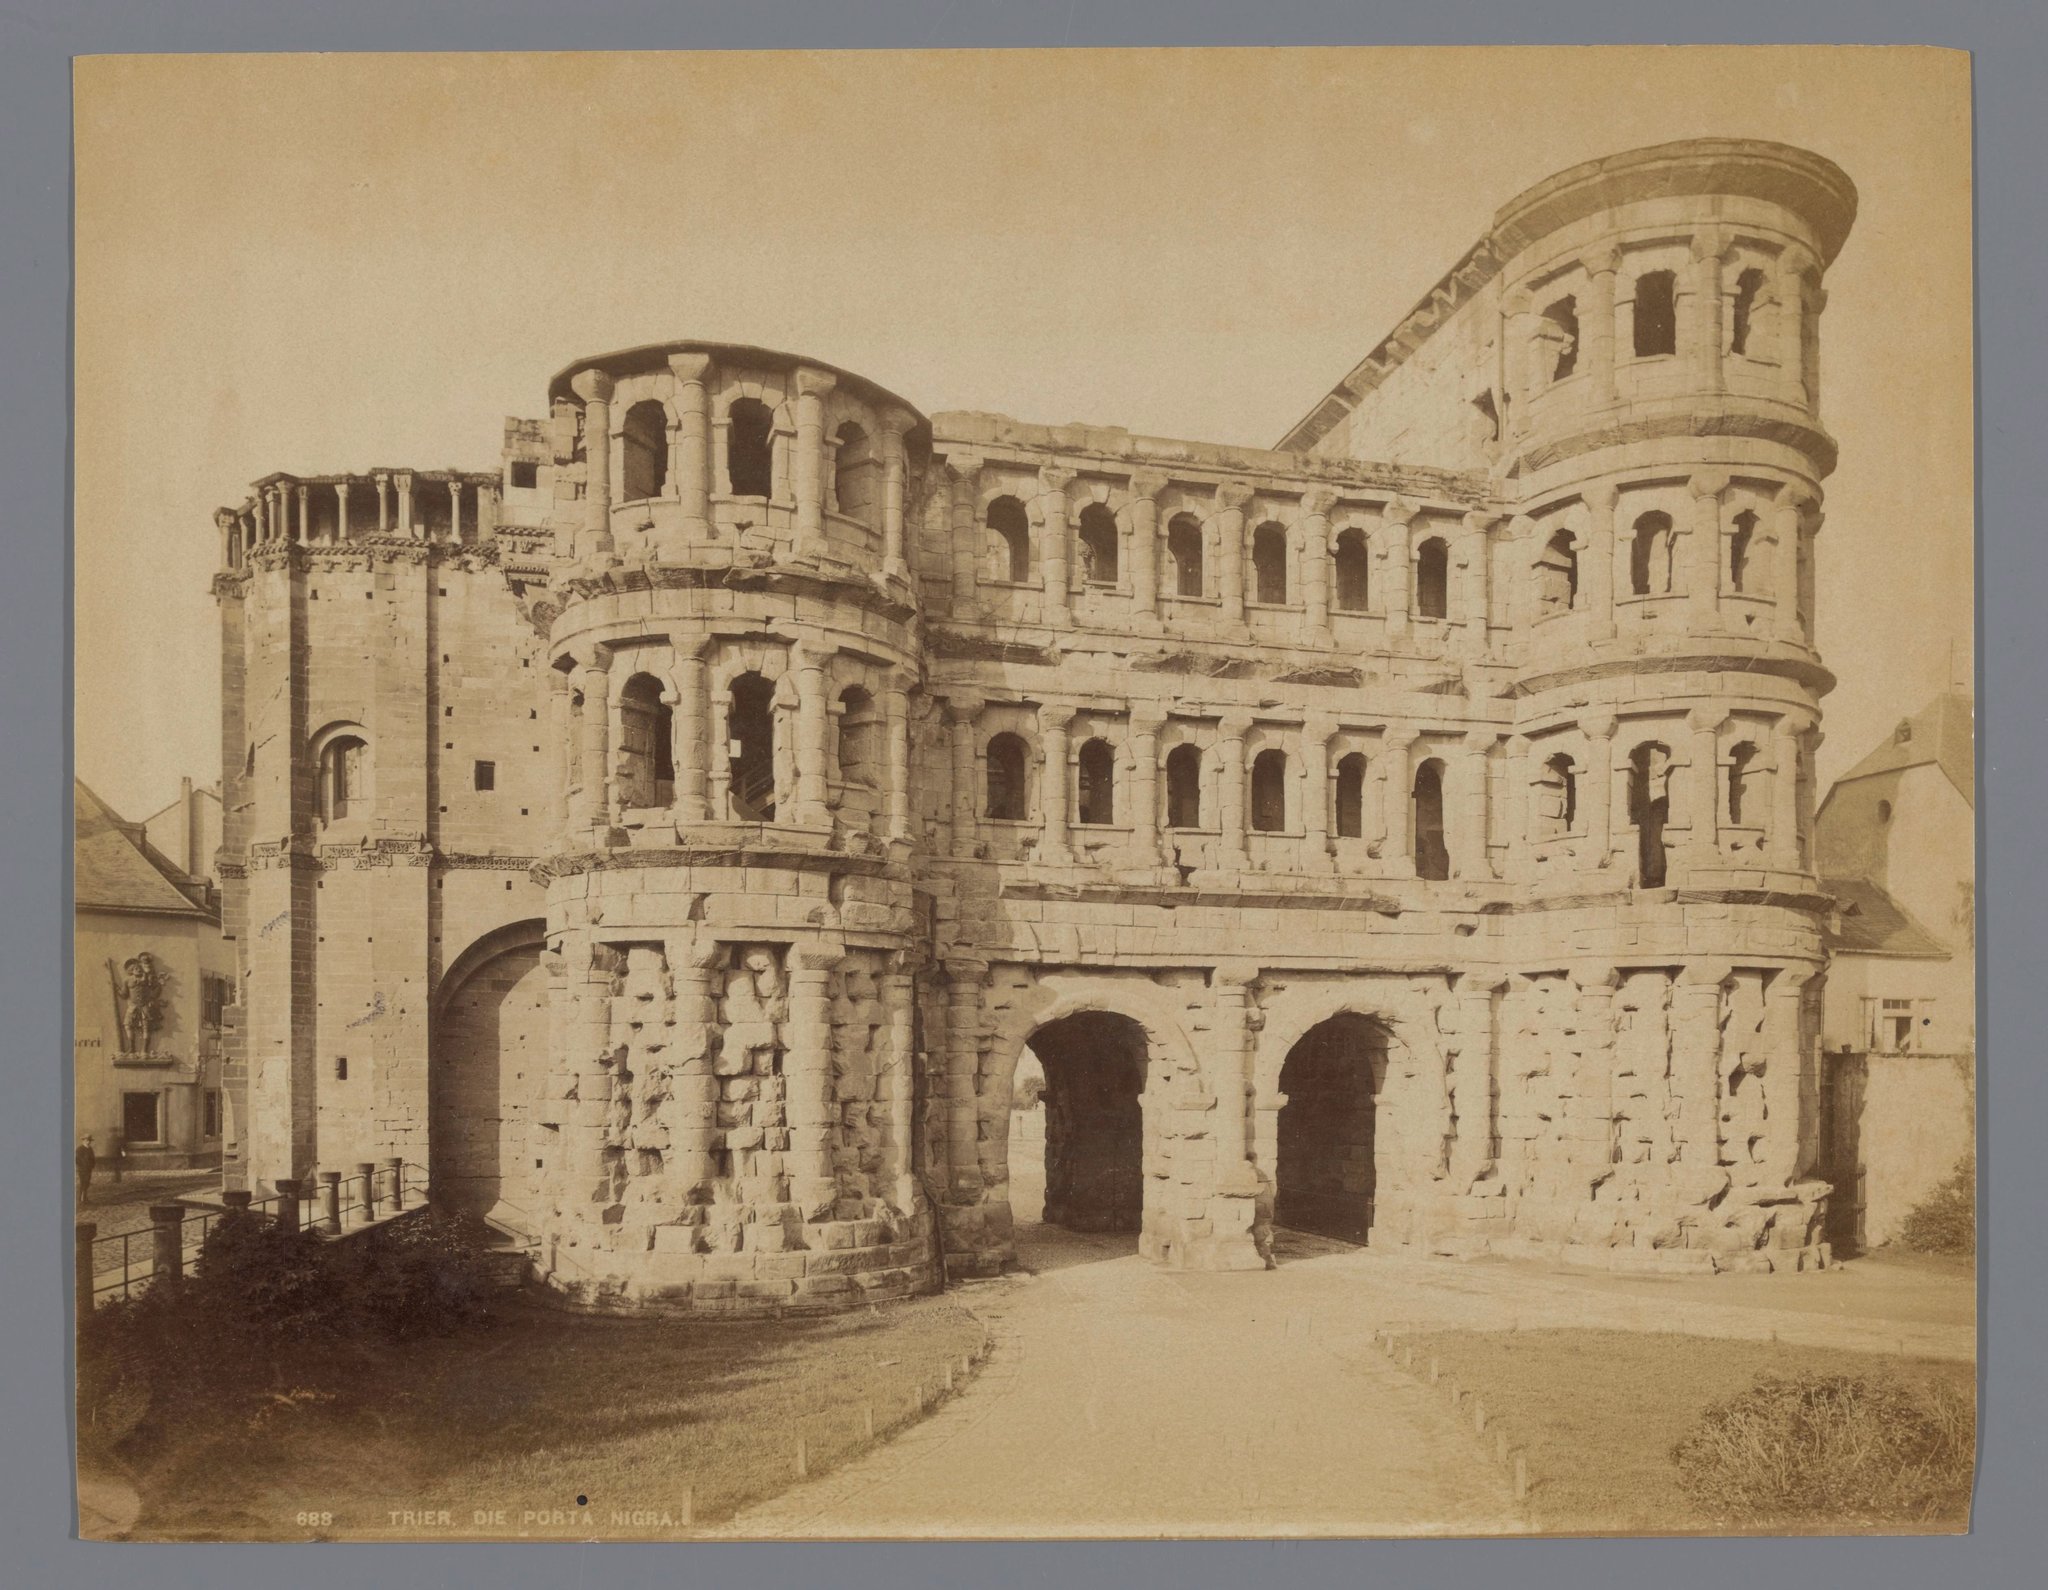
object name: photograph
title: Porta Nigra in Trier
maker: Anonymous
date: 1860-1890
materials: paper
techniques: albumen print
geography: trier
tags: city-gate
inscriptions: inscription: ‘688 Trier. Die Porte Nigra.’, number: ‘1,10’